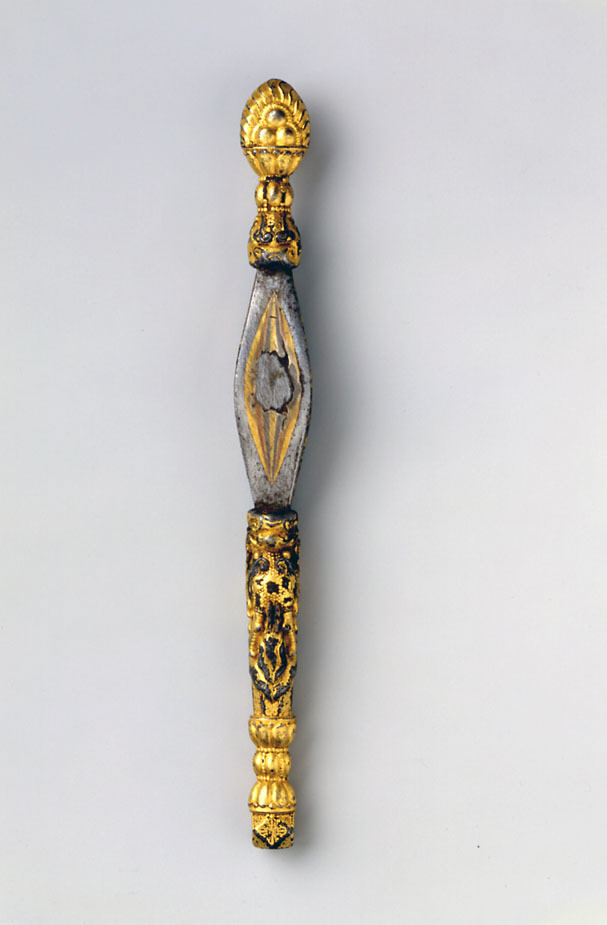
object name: scraper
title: Ritual Scraper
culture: sino-tibetan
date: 1301-1400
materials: iron